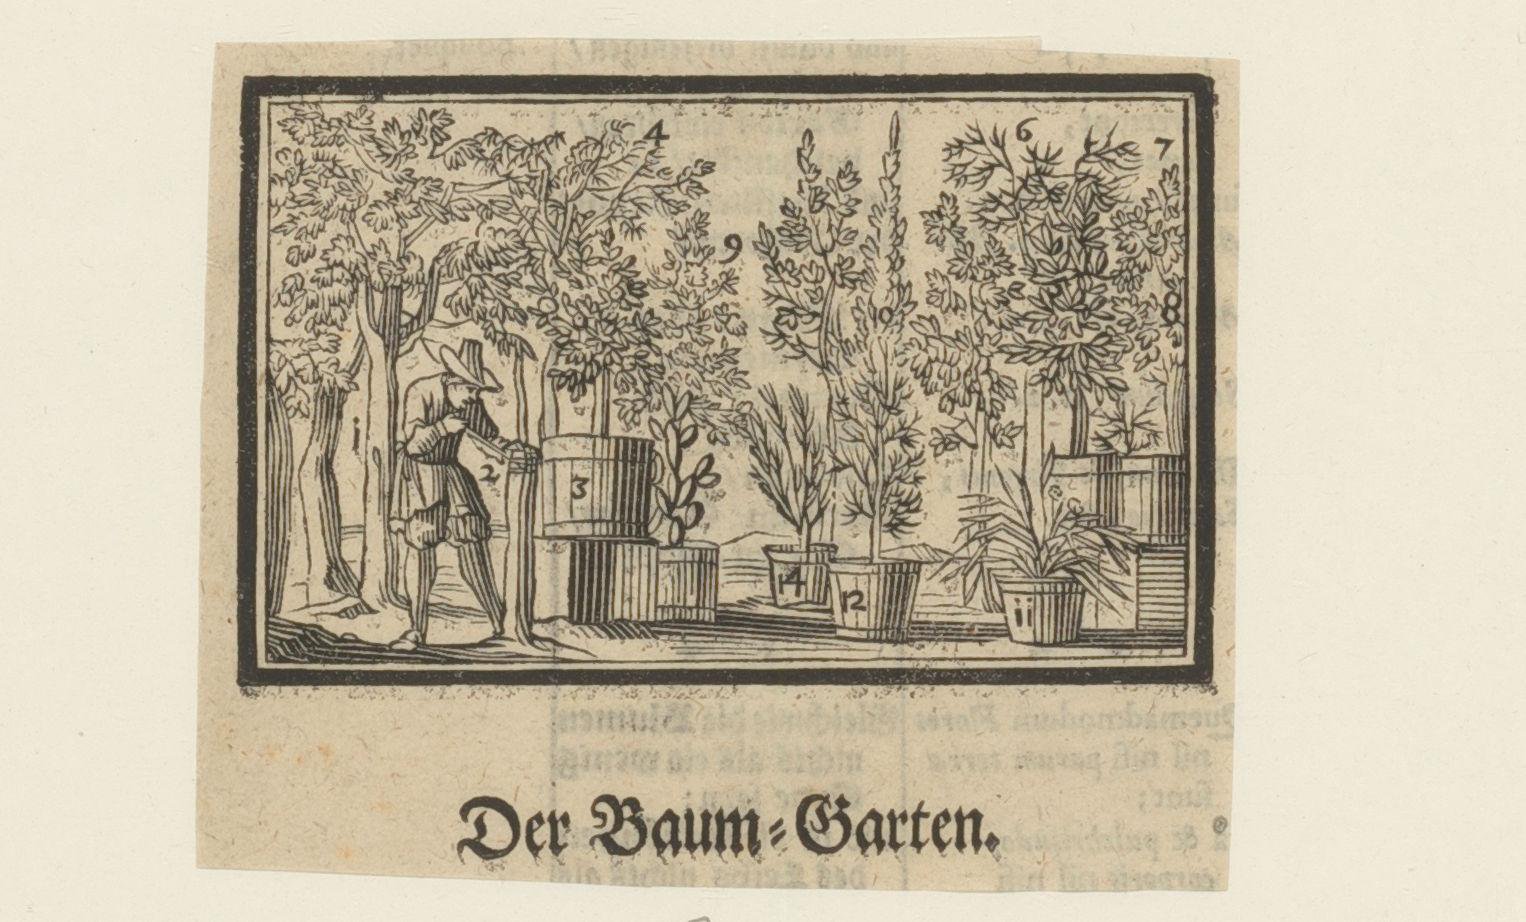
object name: print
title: Tuinder aan het werk in een bomentuin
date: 1719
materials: paper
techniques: letterpress printing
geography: nuremberg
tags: trees, gardening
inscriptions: stamp, collector's mark: Lugt 1641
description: Prent uit: Comenius, Johannes Amosius. Orbis sensualium picti pars prima (...). Neurenberg: Martin Endter, 1719, dl. 2, p. 362. Prent eerder gebruikt in: Comenius, Johannes Amosius. Orbis Sensualium Picti denuo aucti Pars Secunda (...). Neurenberg: Martin Endter, 1730, dl. 2.